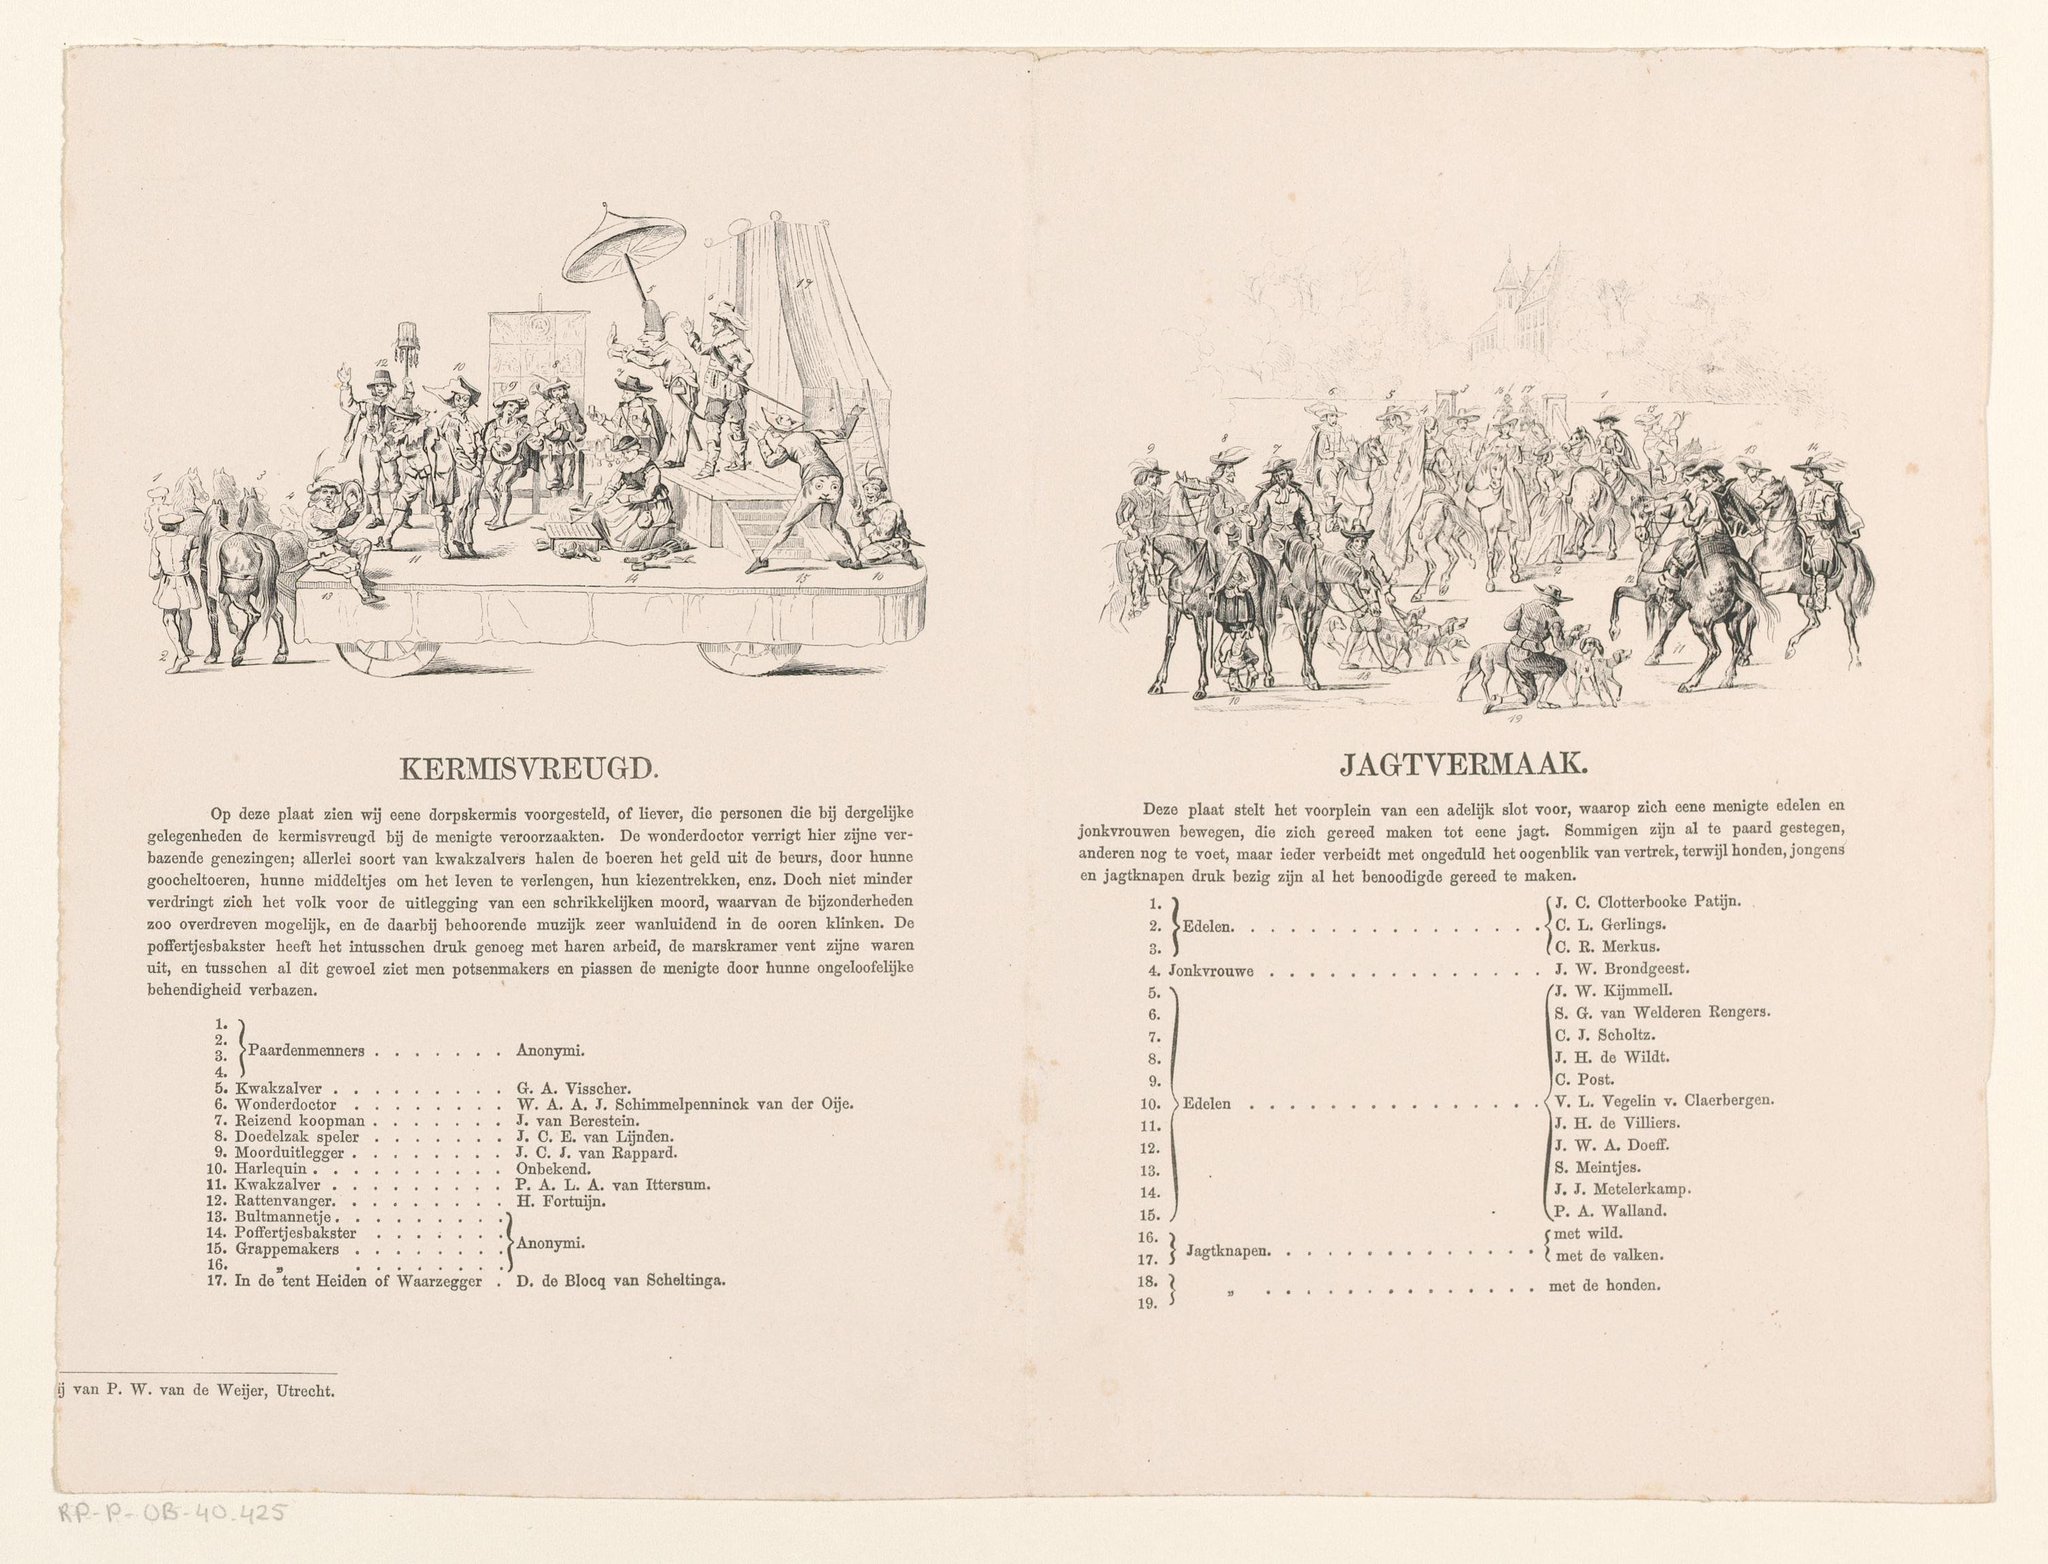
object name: print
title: Kermisvreugd / Jagtvermaak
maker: pieter wilhelmus van de weijer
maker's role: print maker, printer, publisher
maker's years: 1816-1880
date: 1856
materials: paper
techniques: letterpress printing, lithograph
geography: utrecht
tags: students' pageant, costumes used in pageants, utrecht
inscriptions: collector's mark: Lugt 2228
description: Blad met een verklaring en legenda voor de zesde en zevende prent van een groep van zeven prenten met verklaring van de historische optocht in maskerade opgevoerd door de studenten van de vereniging Mutua Fides van de Utrechtse Hogeschool op 25 juni 1856 ter gelegenheid van de viering van haar 220-jarige bestaan.